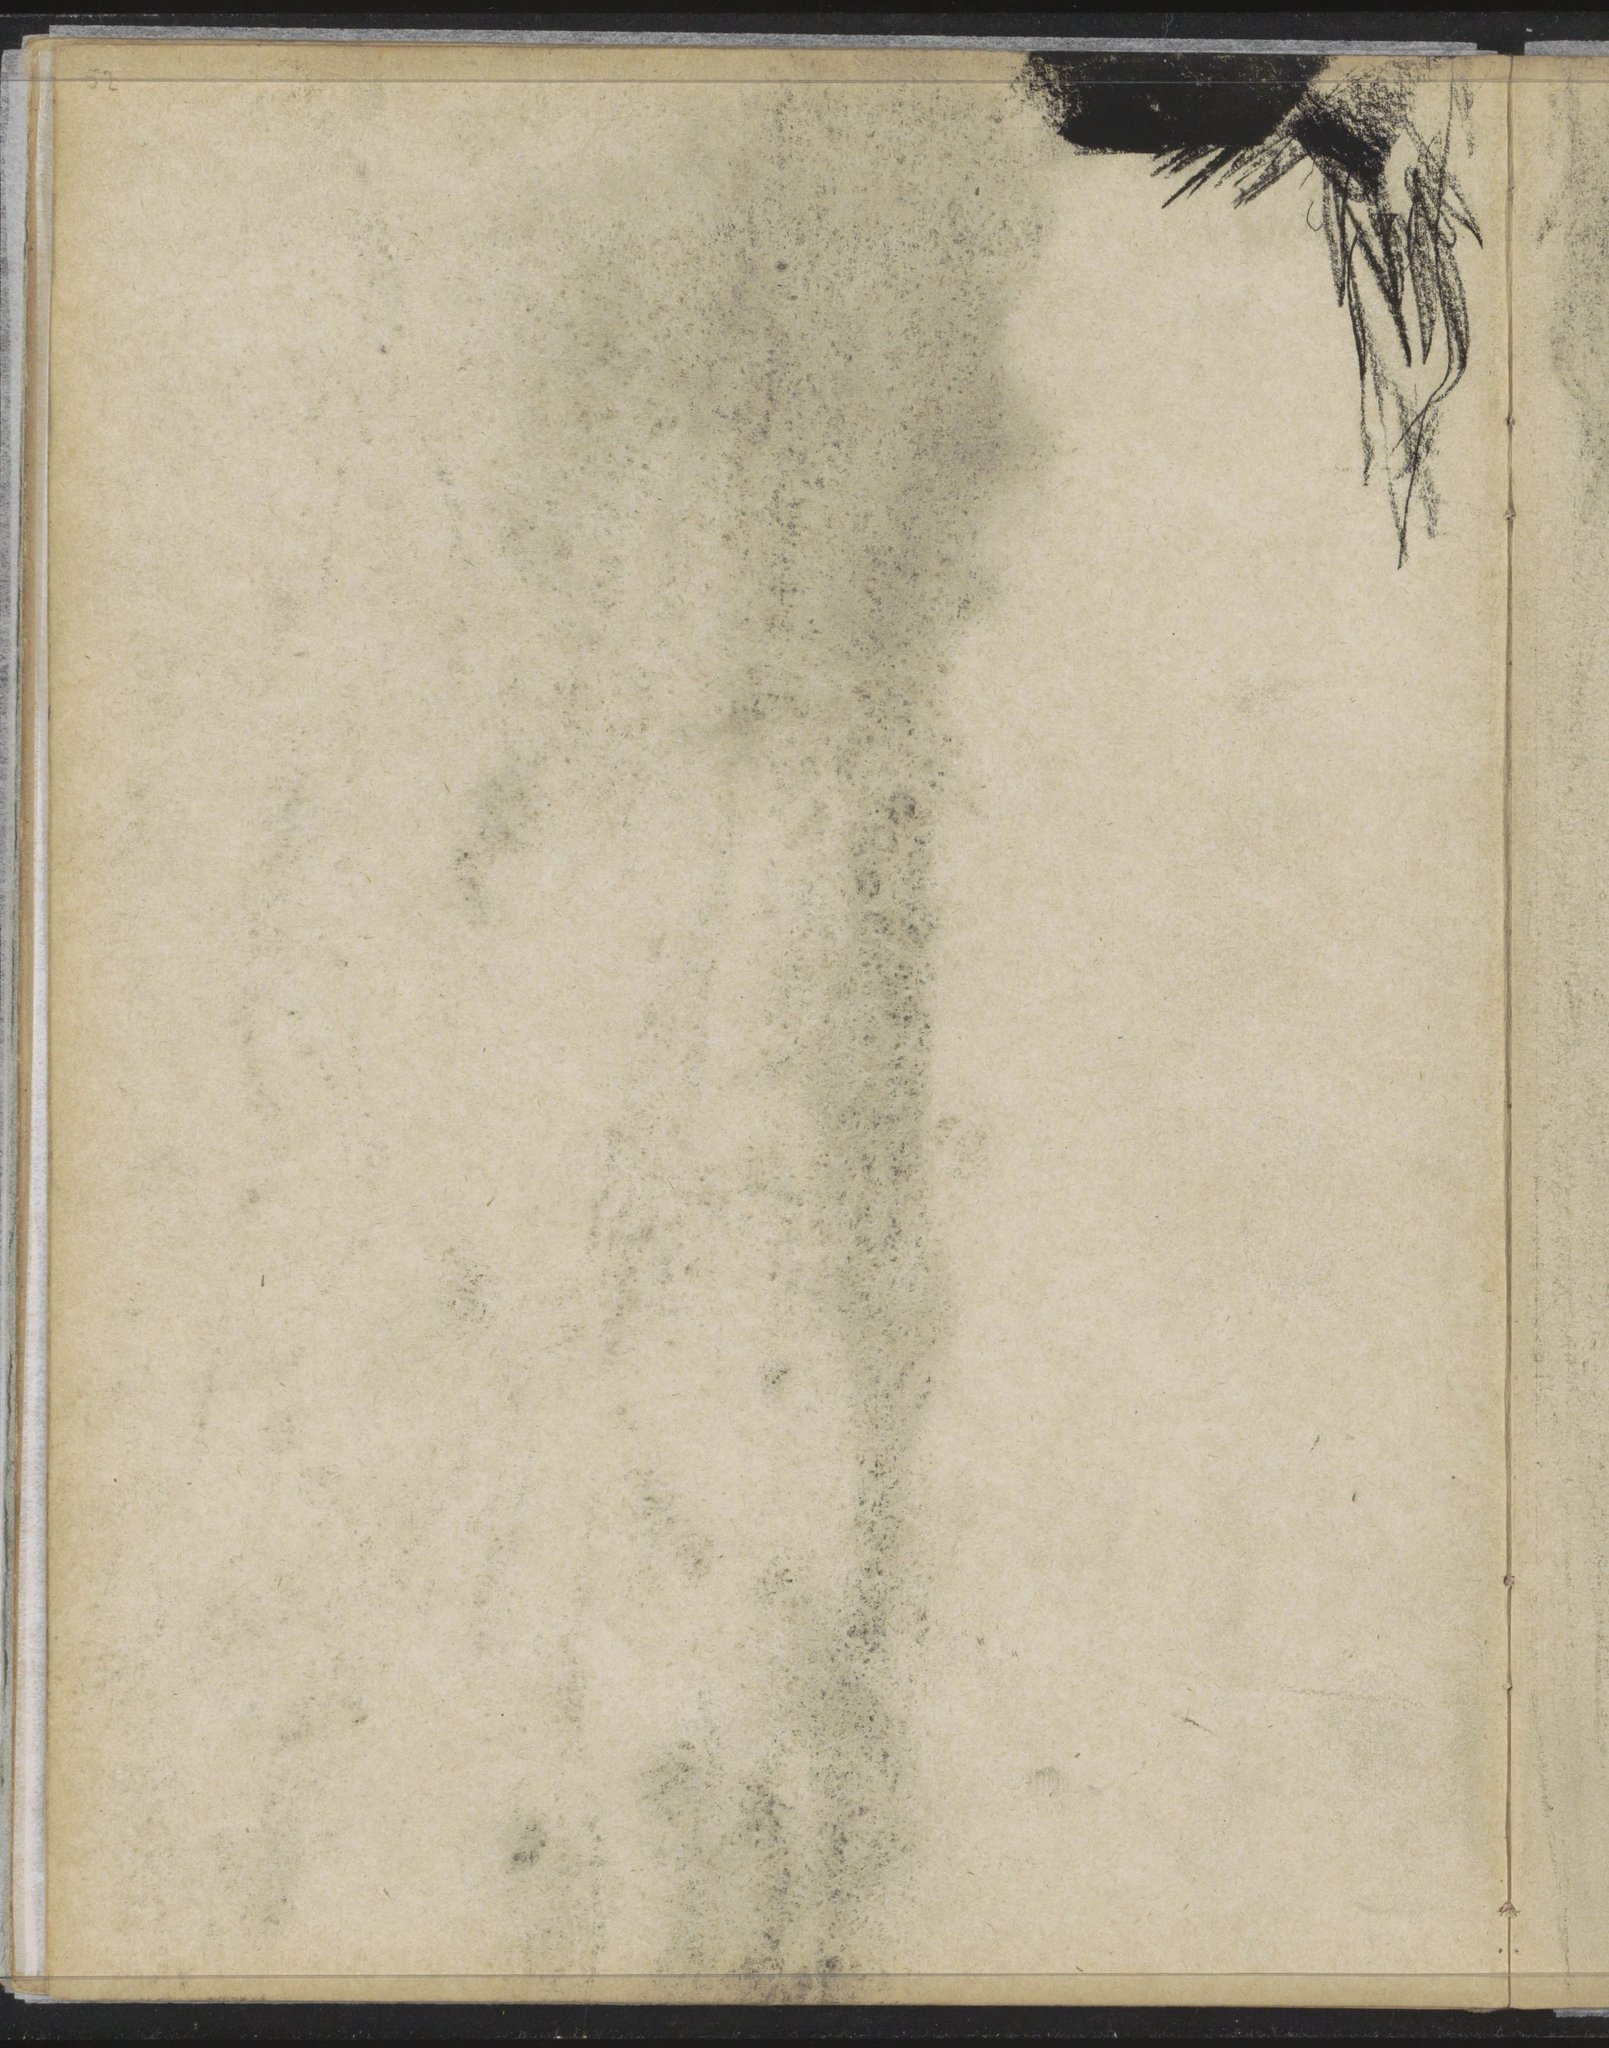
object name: sketchbook leaf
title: Studie, mogelijk van een landschap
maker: willem witsen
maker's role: draughtsman, painter, print maker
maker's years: 1860-1923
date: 1884-1887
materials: chalk, paper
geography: ewijkshoeve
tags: landscapes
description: Pagina 52 uit een schetsboek met 49 bladen.